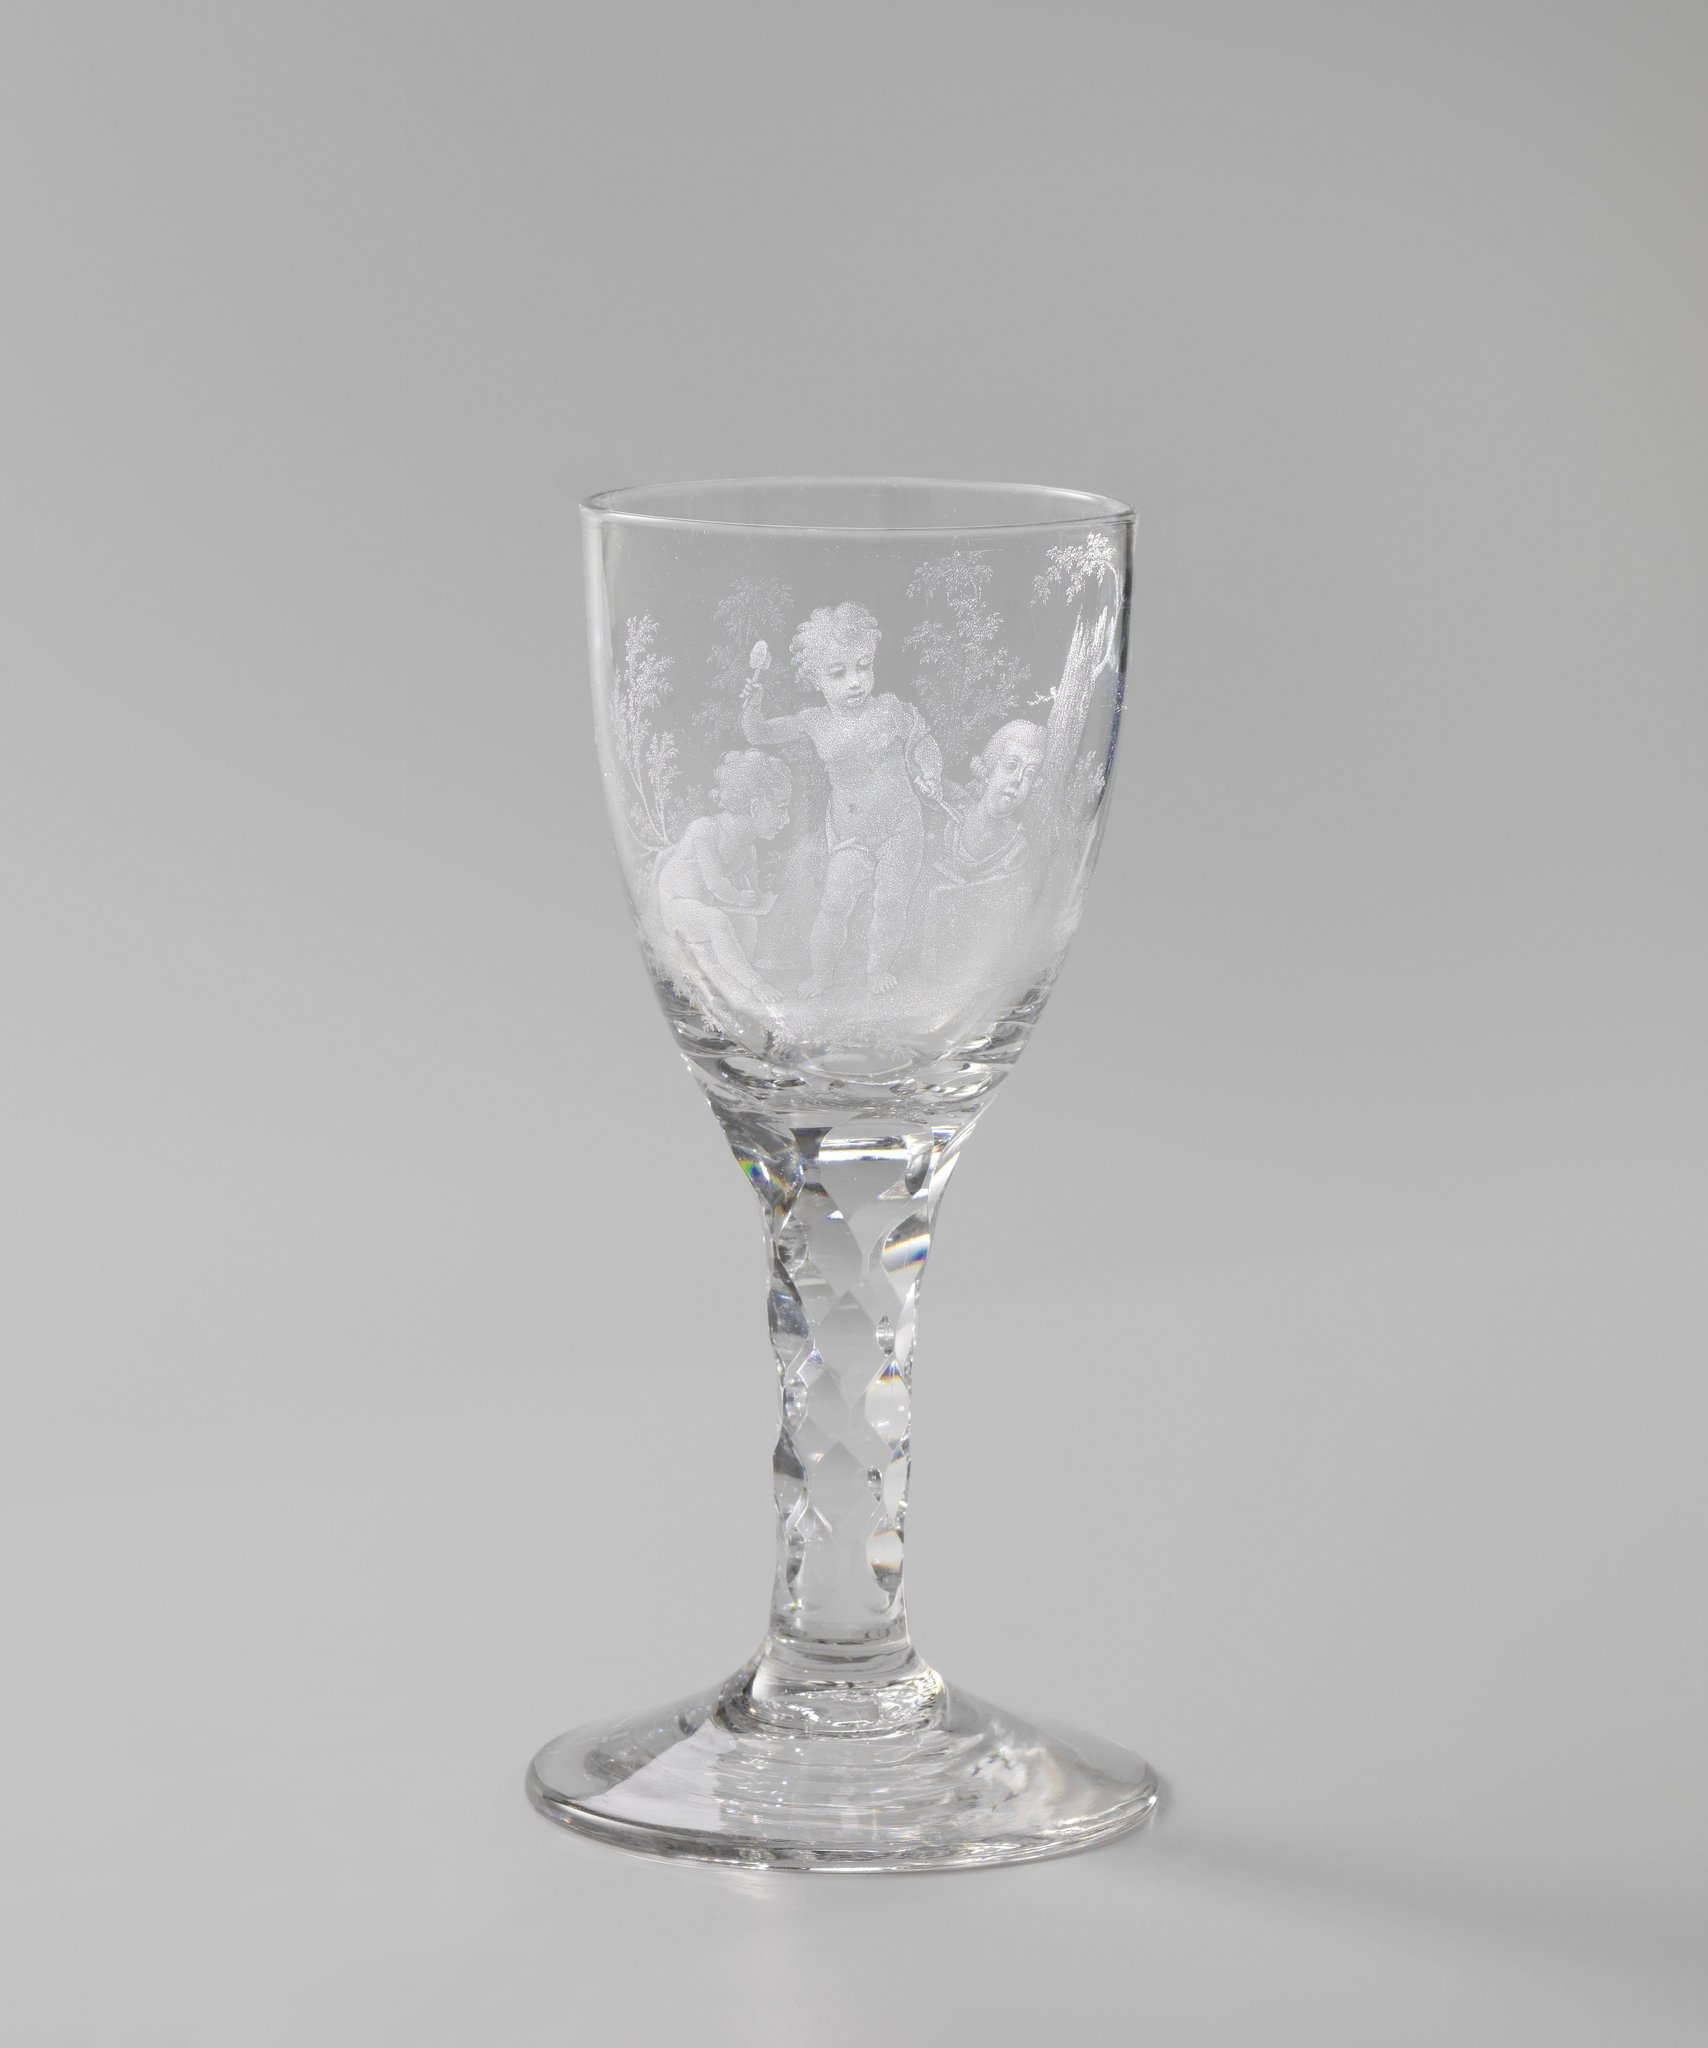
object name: goblet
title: Wine Glass with Two Children Working on a Bust of William V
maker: david wolff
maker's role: glasgraveur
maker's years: 1732-1798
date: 1794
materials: glass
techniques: glassblowing, grinding, engraving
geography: northern netherlands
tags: cupids: 'amores', 'amoretti', 'putti'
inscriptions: signature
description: Conische voet. Zich verbredende, in facetgeslepen stam, overgaande in een licht gebogen kelk. Op de kelk, in een landschap, de personificaties van de teken- en beeldhouwkunst, voorgesteld door een zittende putto met een vel papier op zijn knie en een tekenstift in zijn hand en een putto, die met een hamer en bijtel werkt aan een borstbeeld van stadhouder prins Willem V (1748-1806), dat op een rechthoekige sokkel staat. Rechts onder de voorstelling D: Wolff 1794.